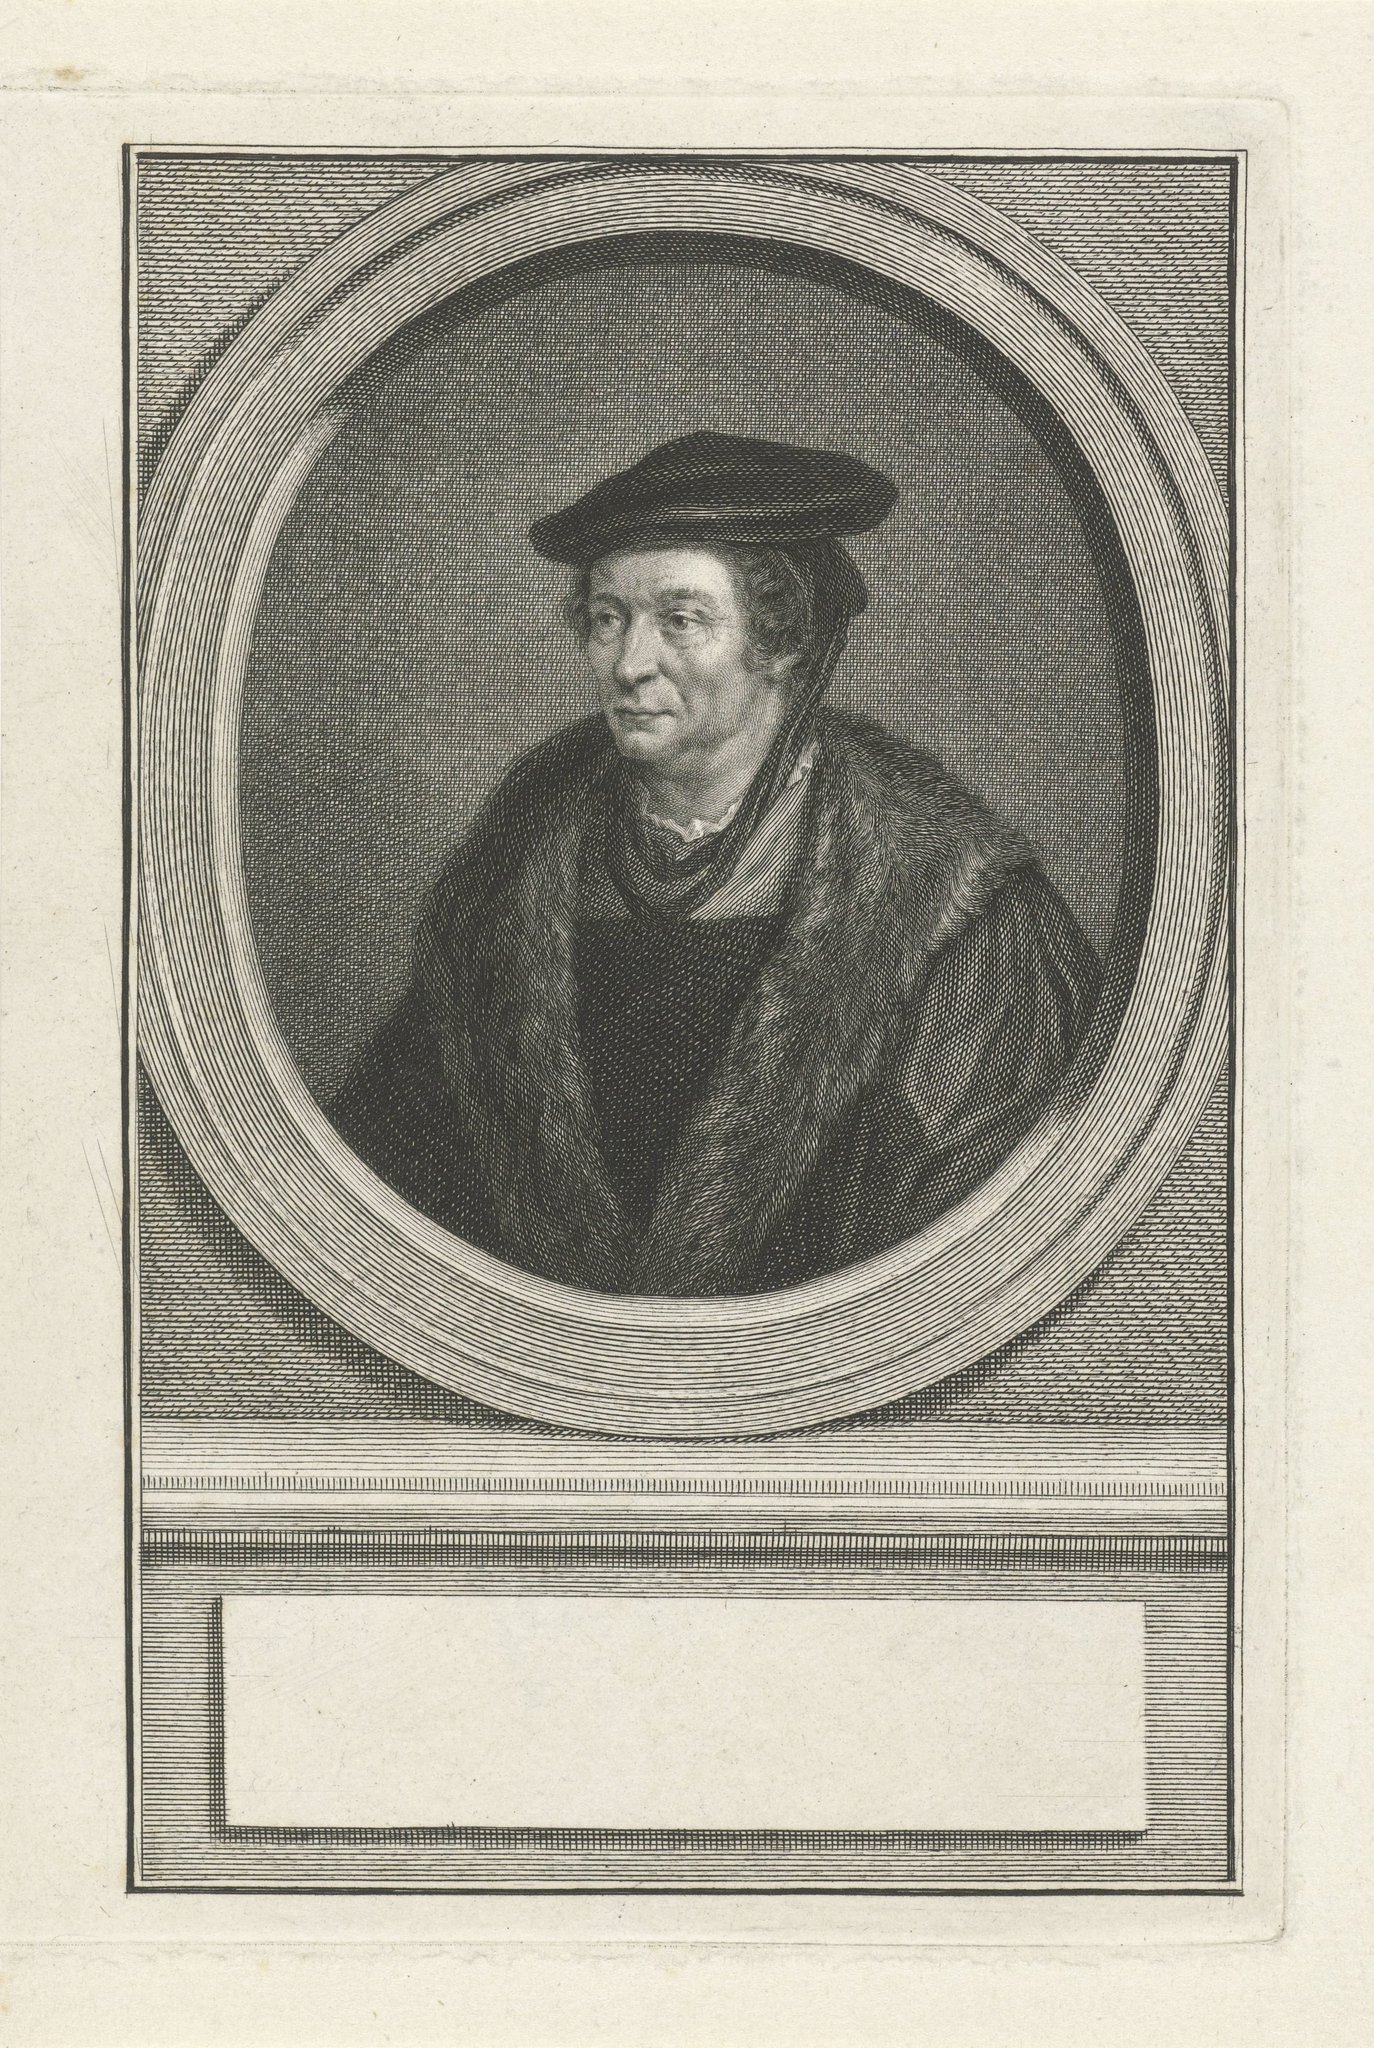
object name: print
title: Portret van Aart van der Goes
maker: jacob houbraken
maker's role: draughtsman, print maker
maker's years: 1698-1780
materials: paper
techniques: engraving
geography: amsterdam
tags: historical persons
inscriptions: collector's mark: Lugt 240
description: Portret van Aart van der Goes in een ovaal. Het portret rust op een plint met daarop een leeg veld voor zijn naam en gegevens.